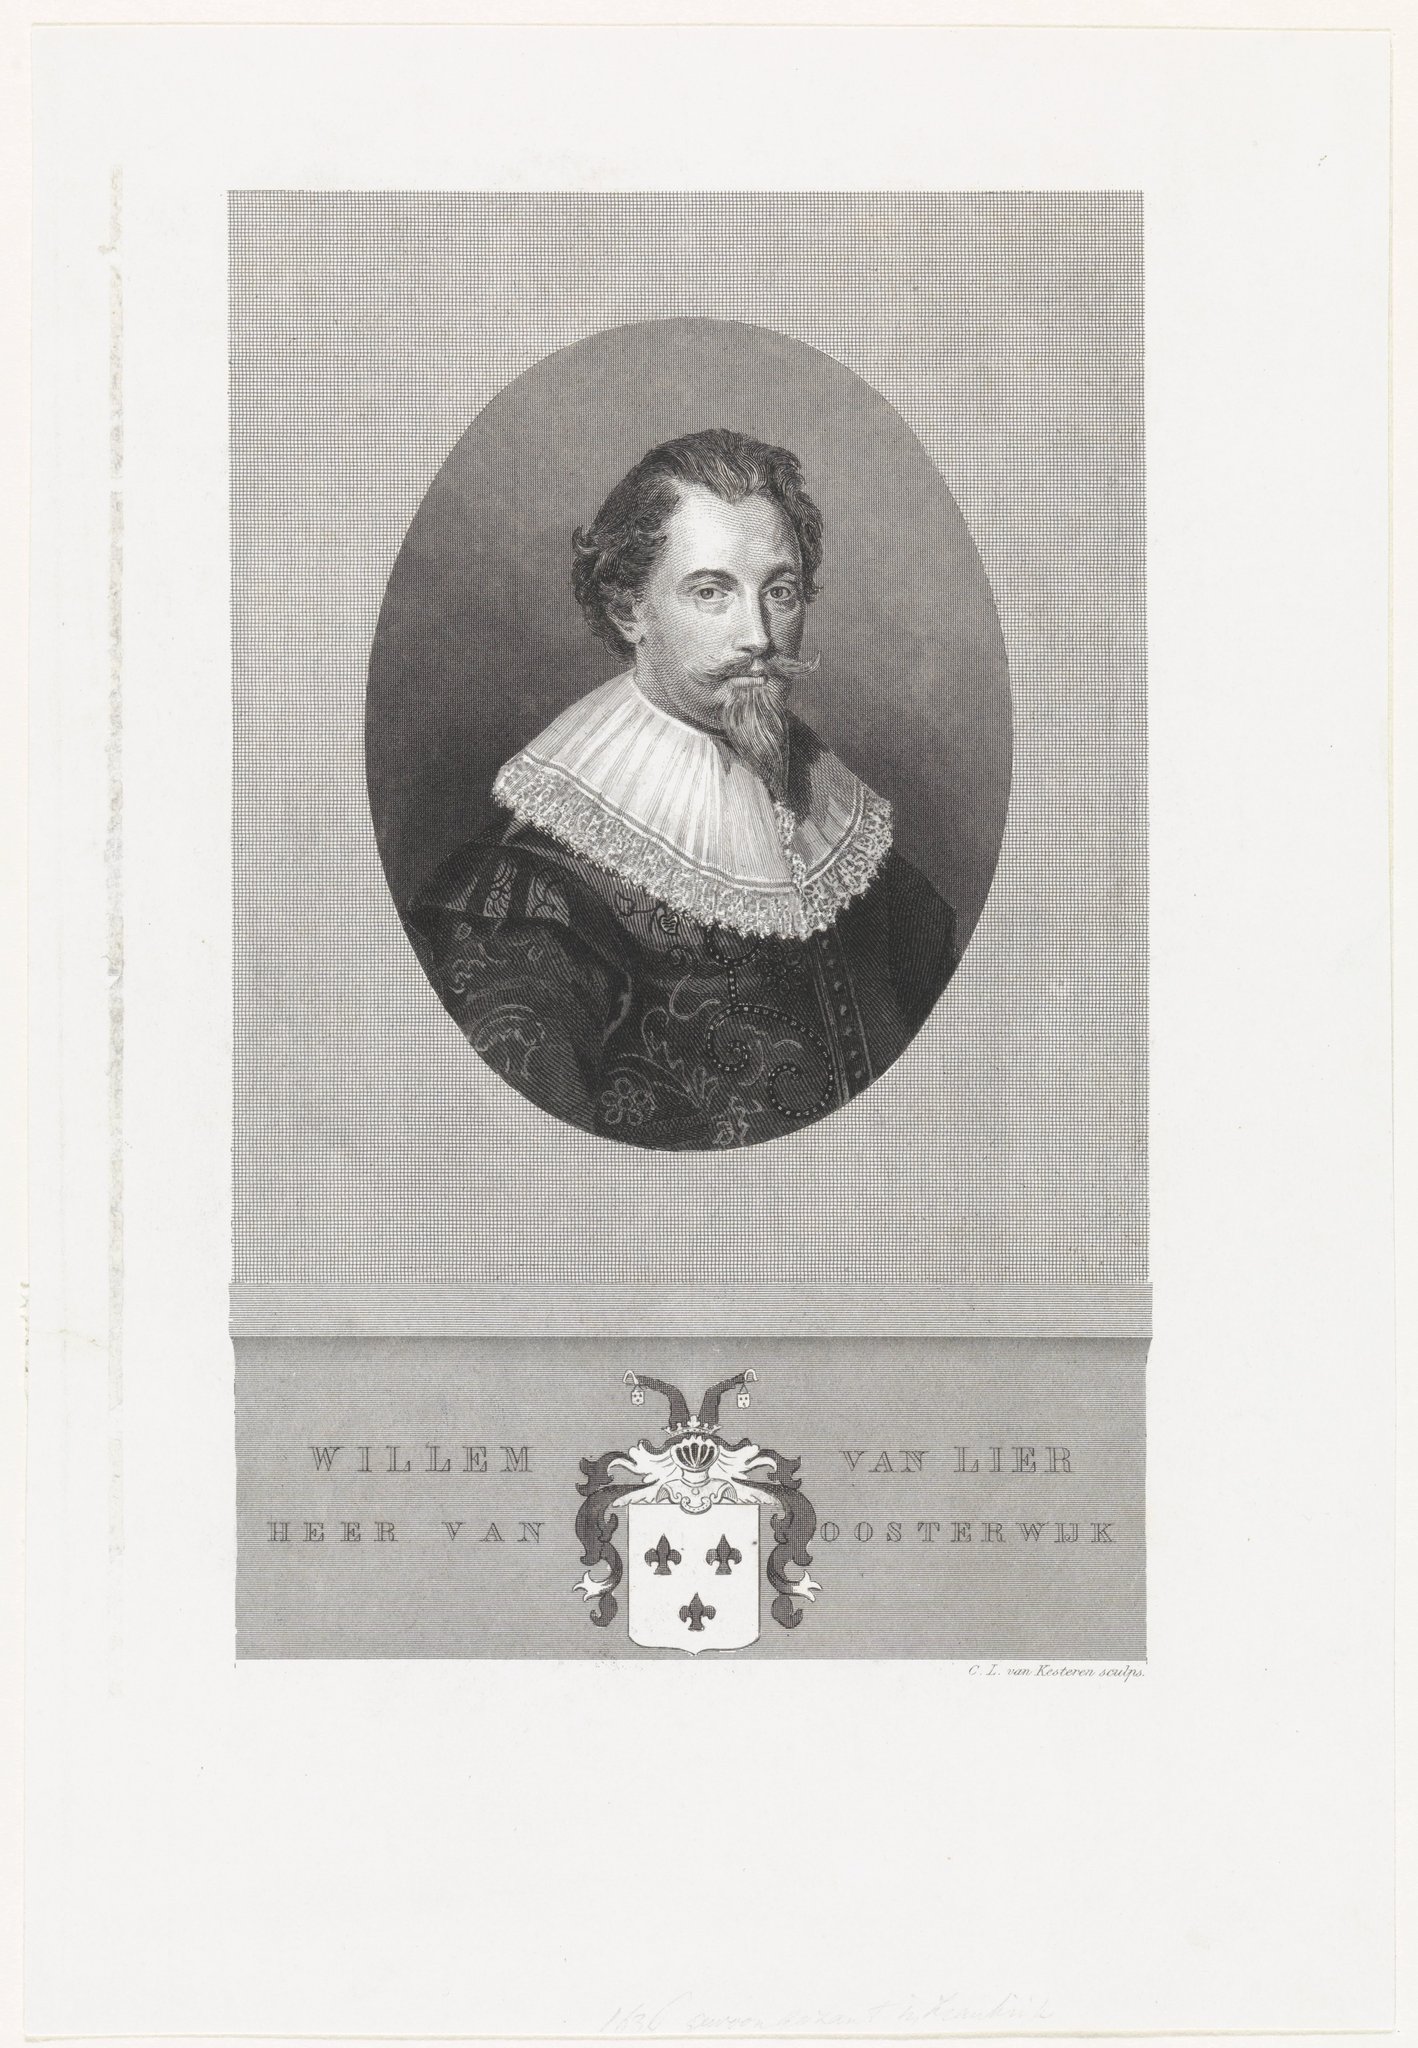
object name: print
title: Willem van Lier Heer van Oosterwijk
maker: christiaan lodewijk van kesteren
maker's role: print maker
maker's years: 1832-1897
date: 1842-1897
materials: paper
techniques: engraving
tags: willemstad, ambassadeur, willem van lier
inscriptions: collector's mark: Lugt 2228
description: Portretbuste van Willem van Lier, ambassadeur en heer van Oosterwijk. In de marge staat zijn familiewapen; drie afgesneden zwarte lelies met deltavormige voet.